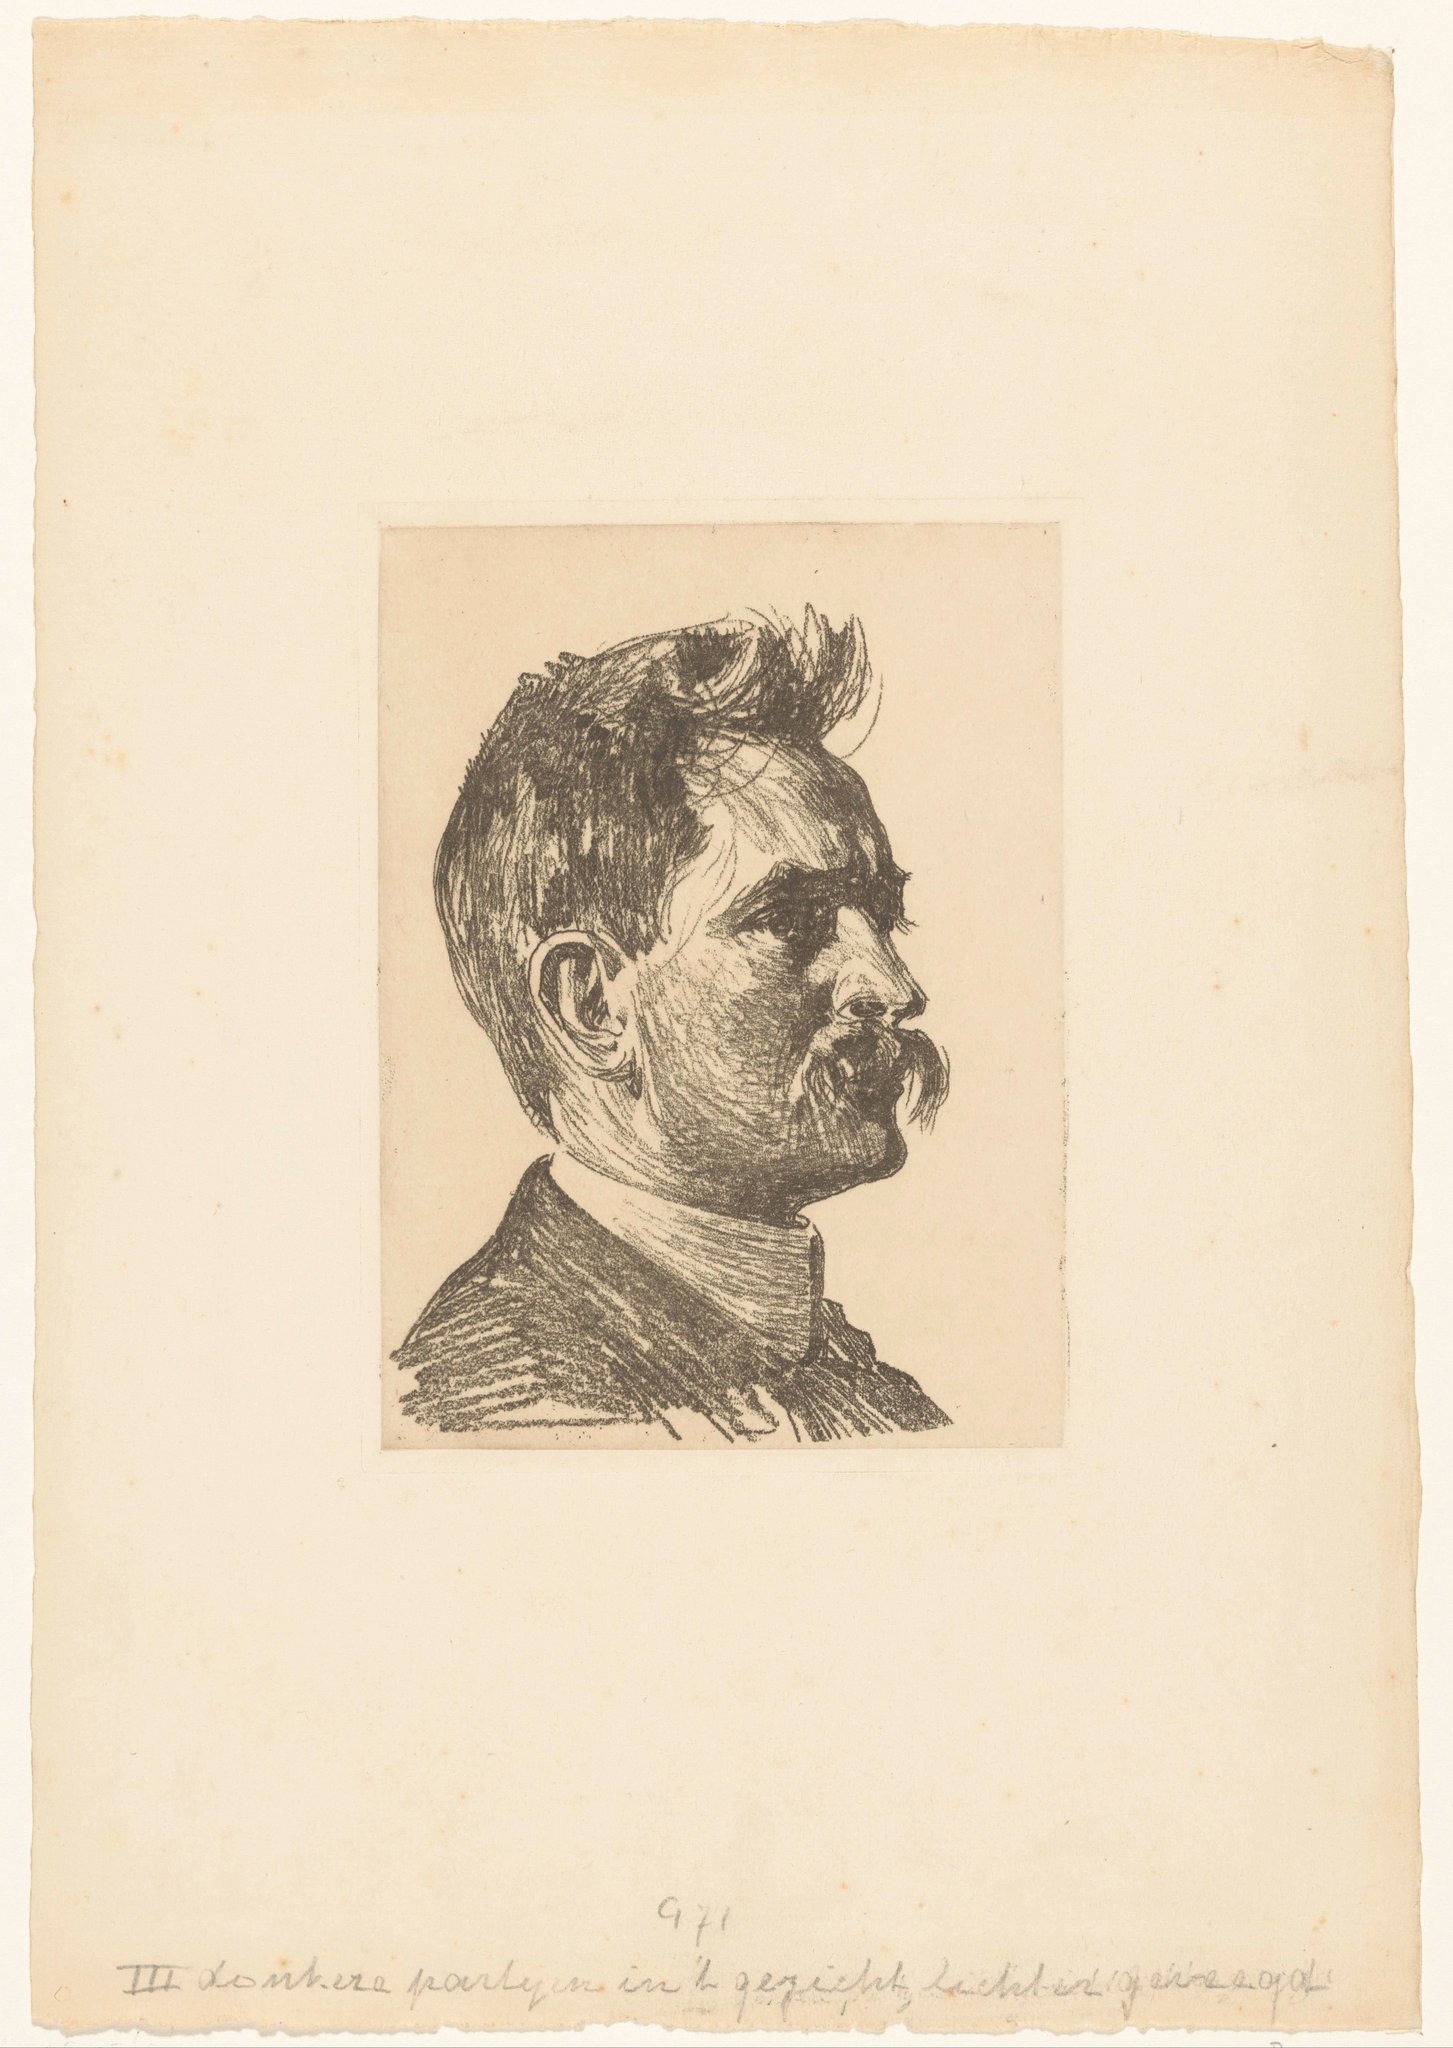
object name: print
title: Portret van Jan Hofker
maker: willem witsen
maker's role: draughtsman, painter, print maker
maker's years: 1860-1923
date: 1905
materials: paper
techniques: soft ground etching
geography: amsterdam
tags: portrait of a writer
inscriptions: inscription: ‘III donkere partijen in 't gezicht lichter geveegd’, watermark